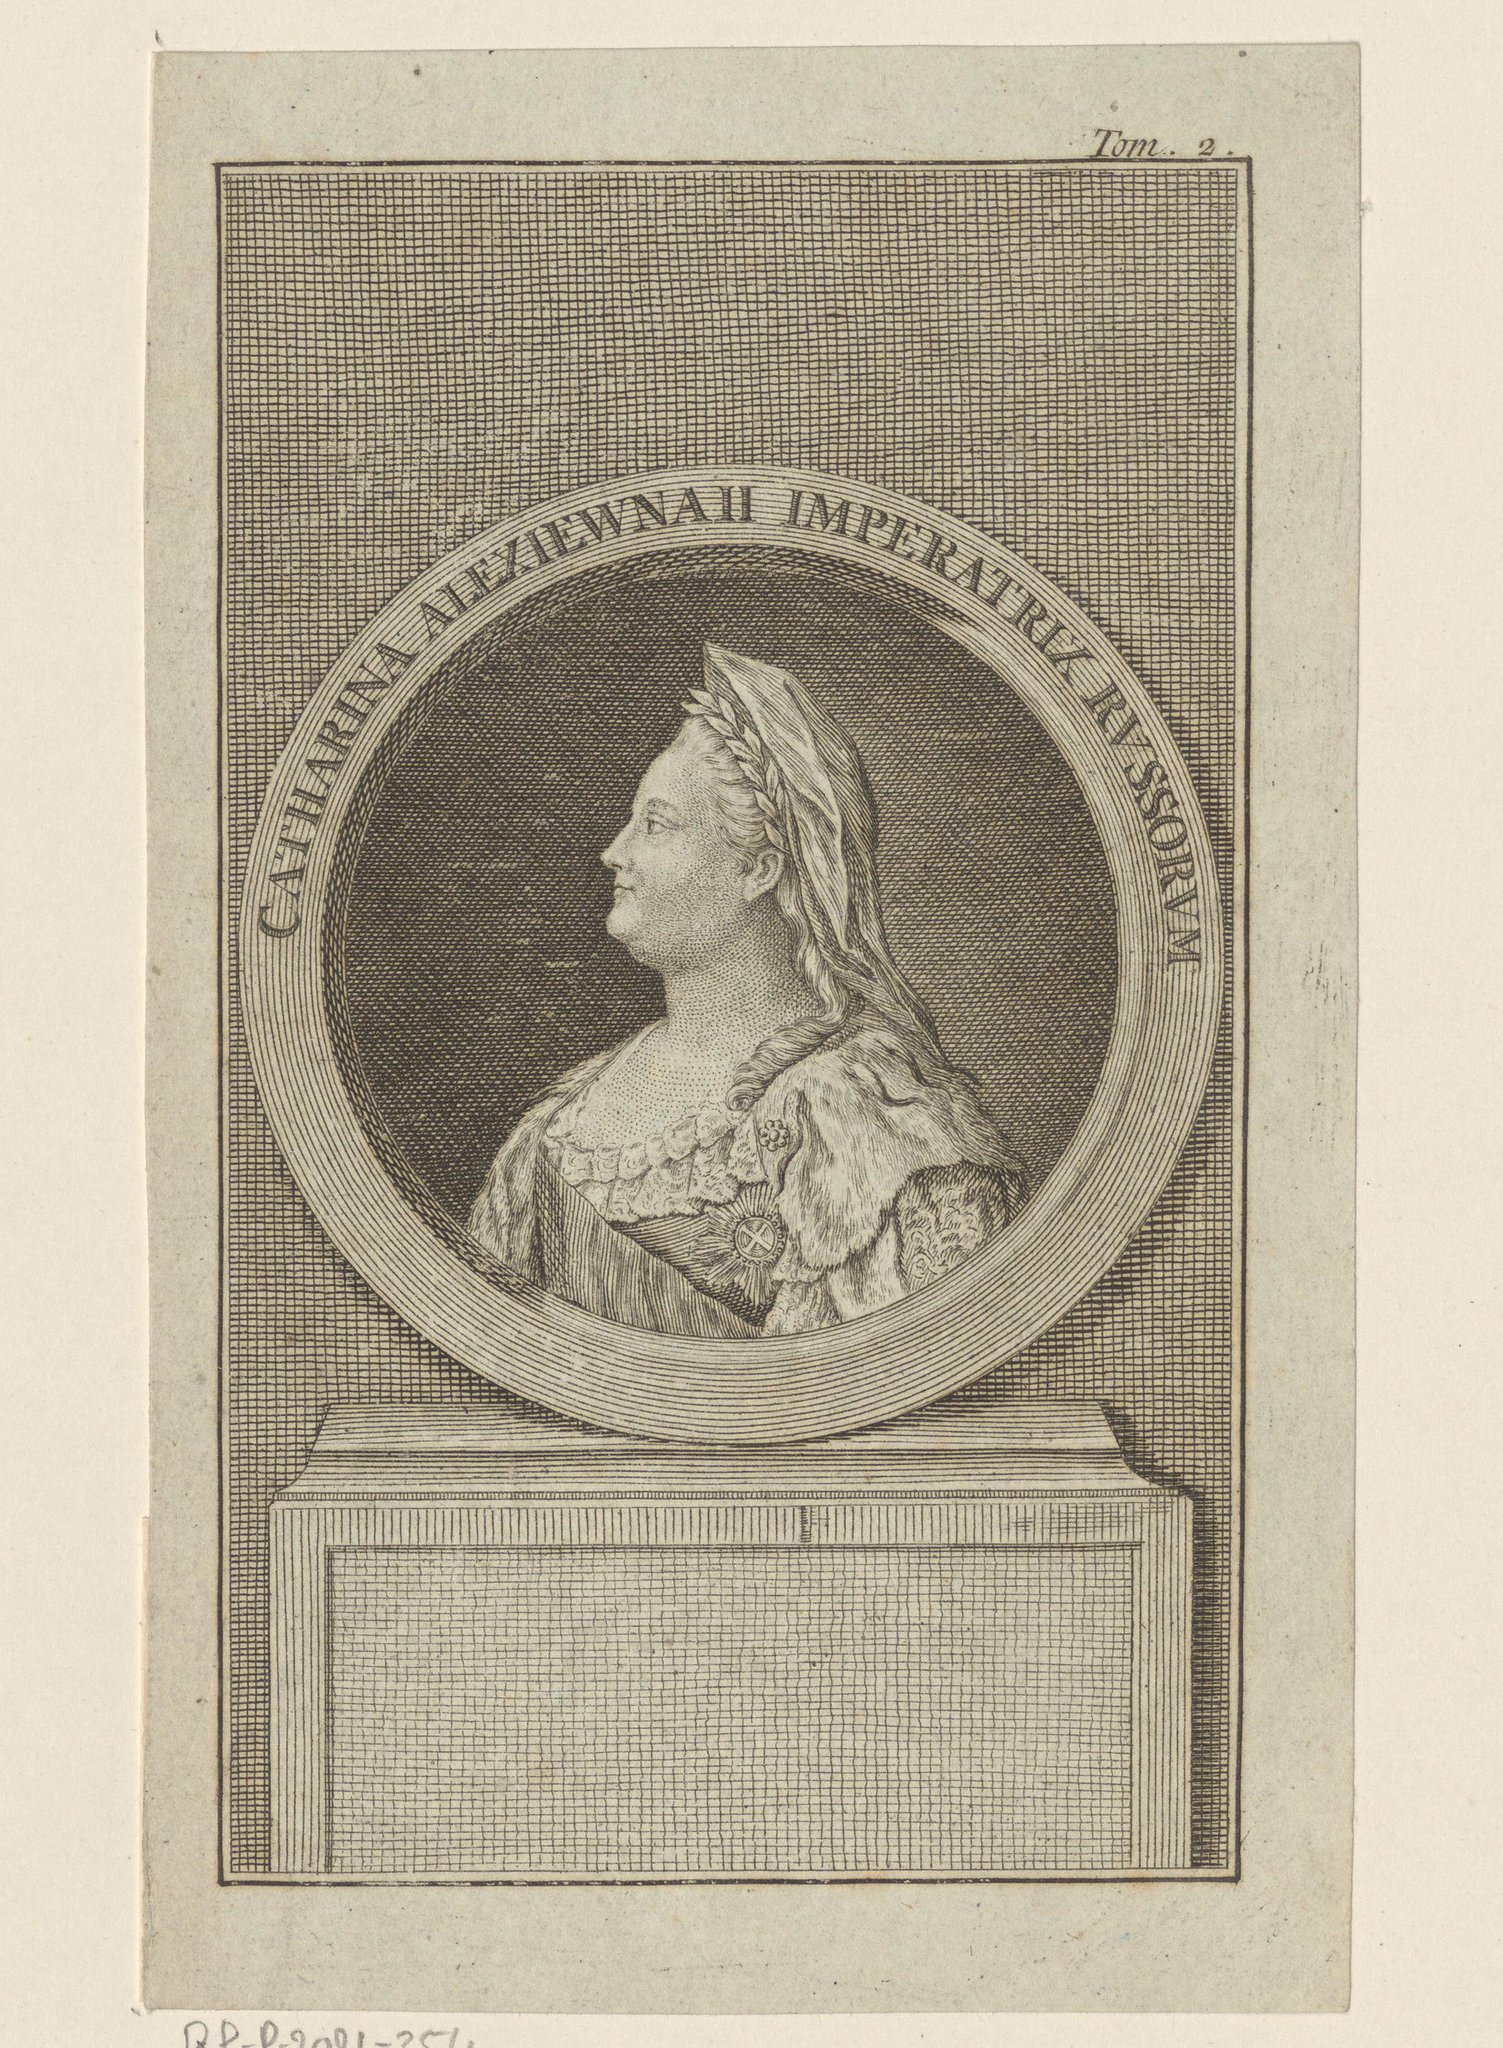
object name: print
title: Portret van Catharina de Grote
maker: Anonymous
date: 1762-1849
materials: paper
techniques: engraving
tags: catharina de grote, historical persons - bb - woman, emperor - bb - female ruler